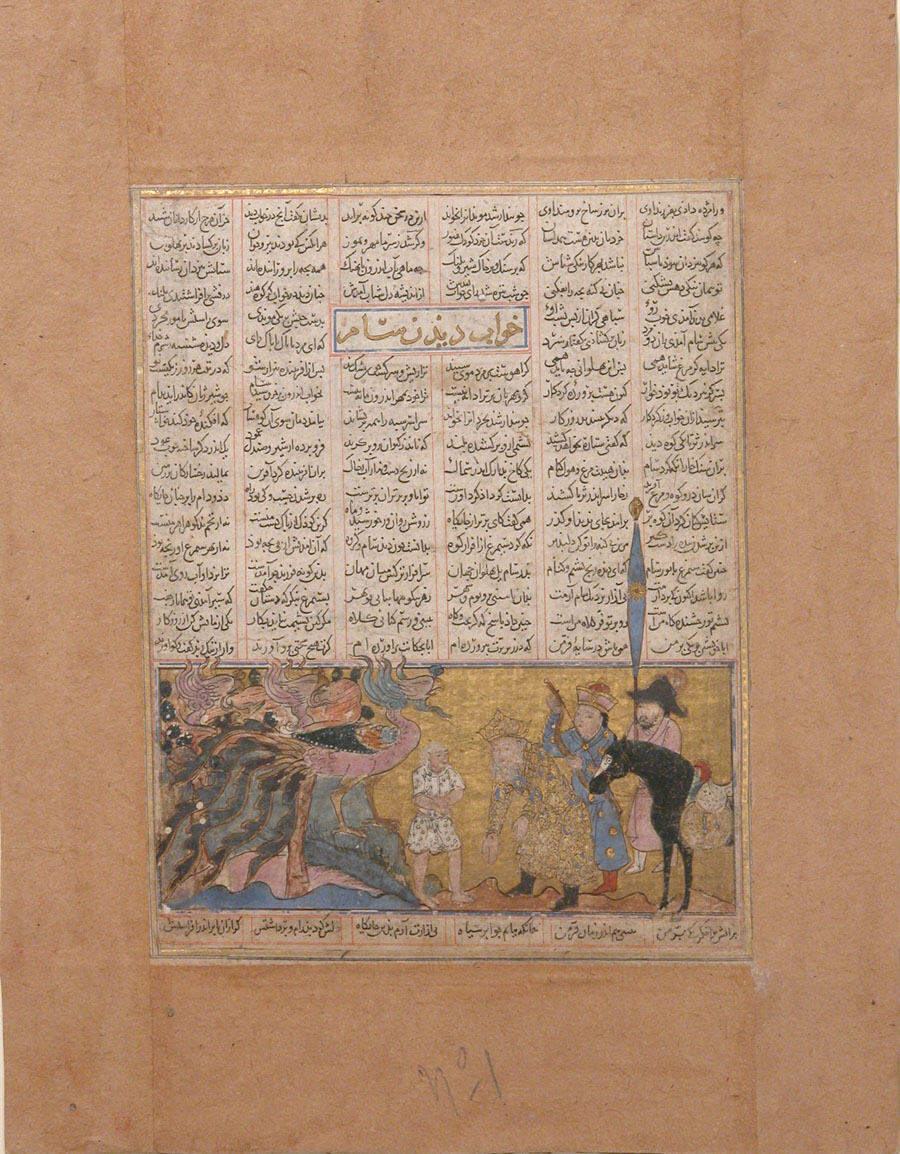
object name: folio from an illustrated manuscript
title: "Zal is Restored to his Father Sam by the Simurgh", Folio from a Shahnama (Book of Kings)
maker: abu'l qasim firdausi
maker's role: author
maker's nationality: iranian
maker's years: 935-1020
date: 1300-1330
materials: gold, ink, paper, silver, watercolor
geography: iran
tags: men,mythical creatures,horses